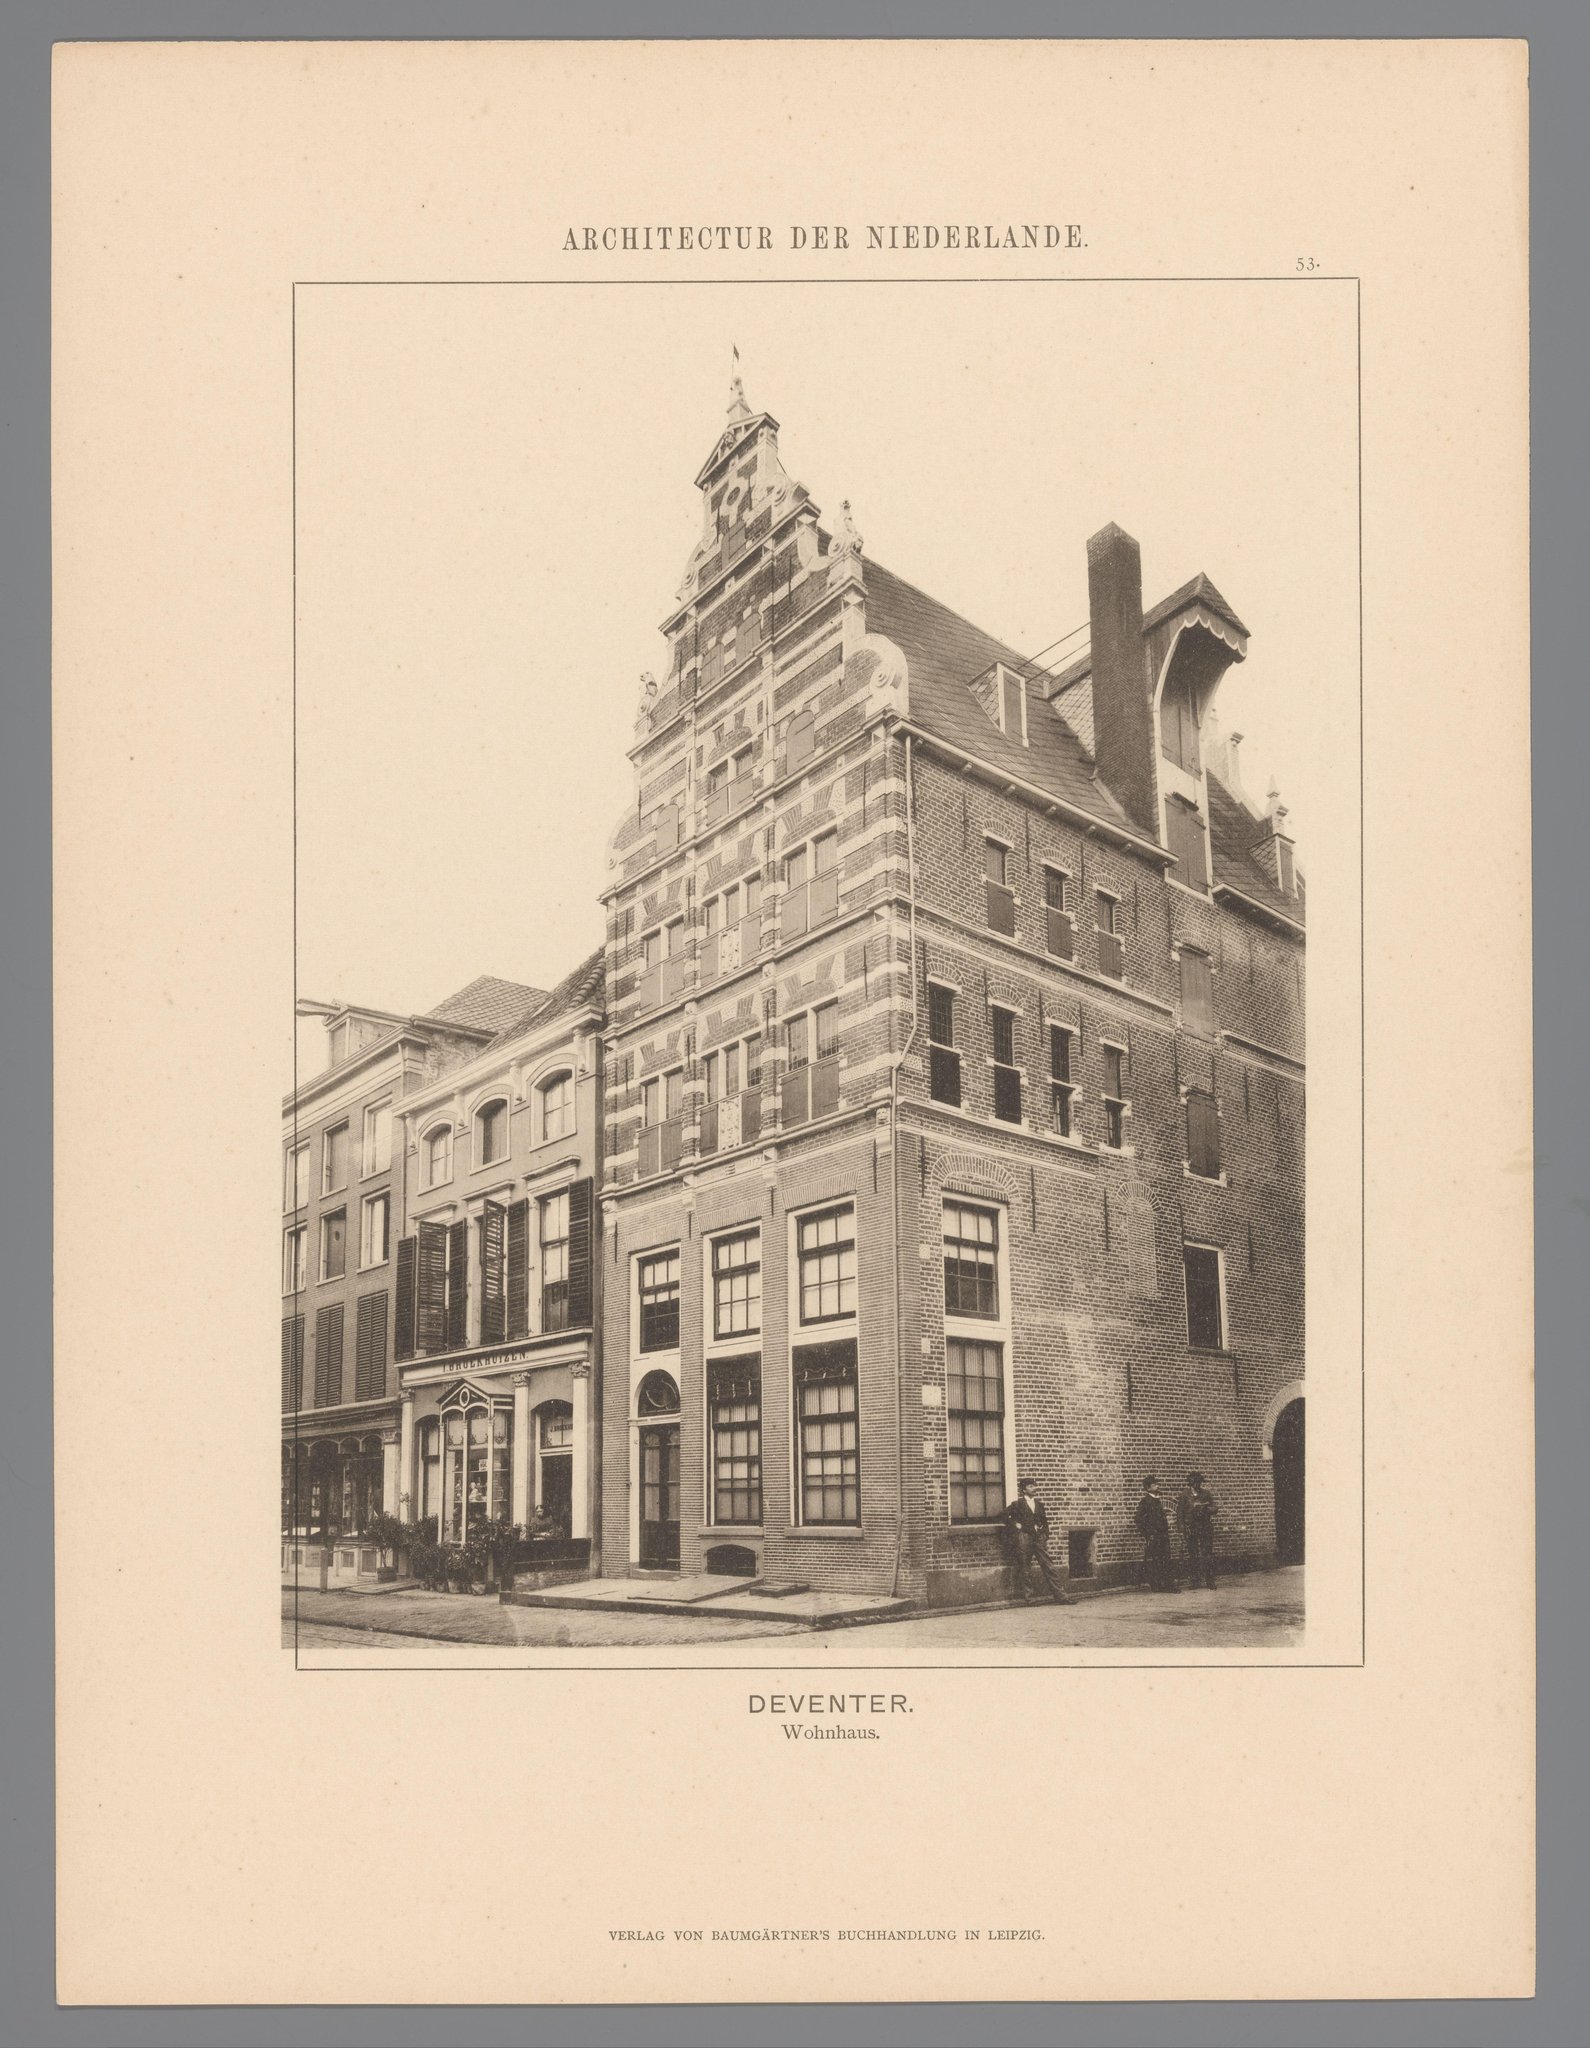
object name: photomechanical print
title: Deventer, Wohnhaus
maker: Anonymous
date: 1894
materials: paper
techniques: photograph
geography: leipzig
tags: decorated gable, stone tablet in façade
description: Afdruk uit: Krook, L. Architectur der Niederlande. Leipzig: Baumgärtner's Buchhandlung, 1894.